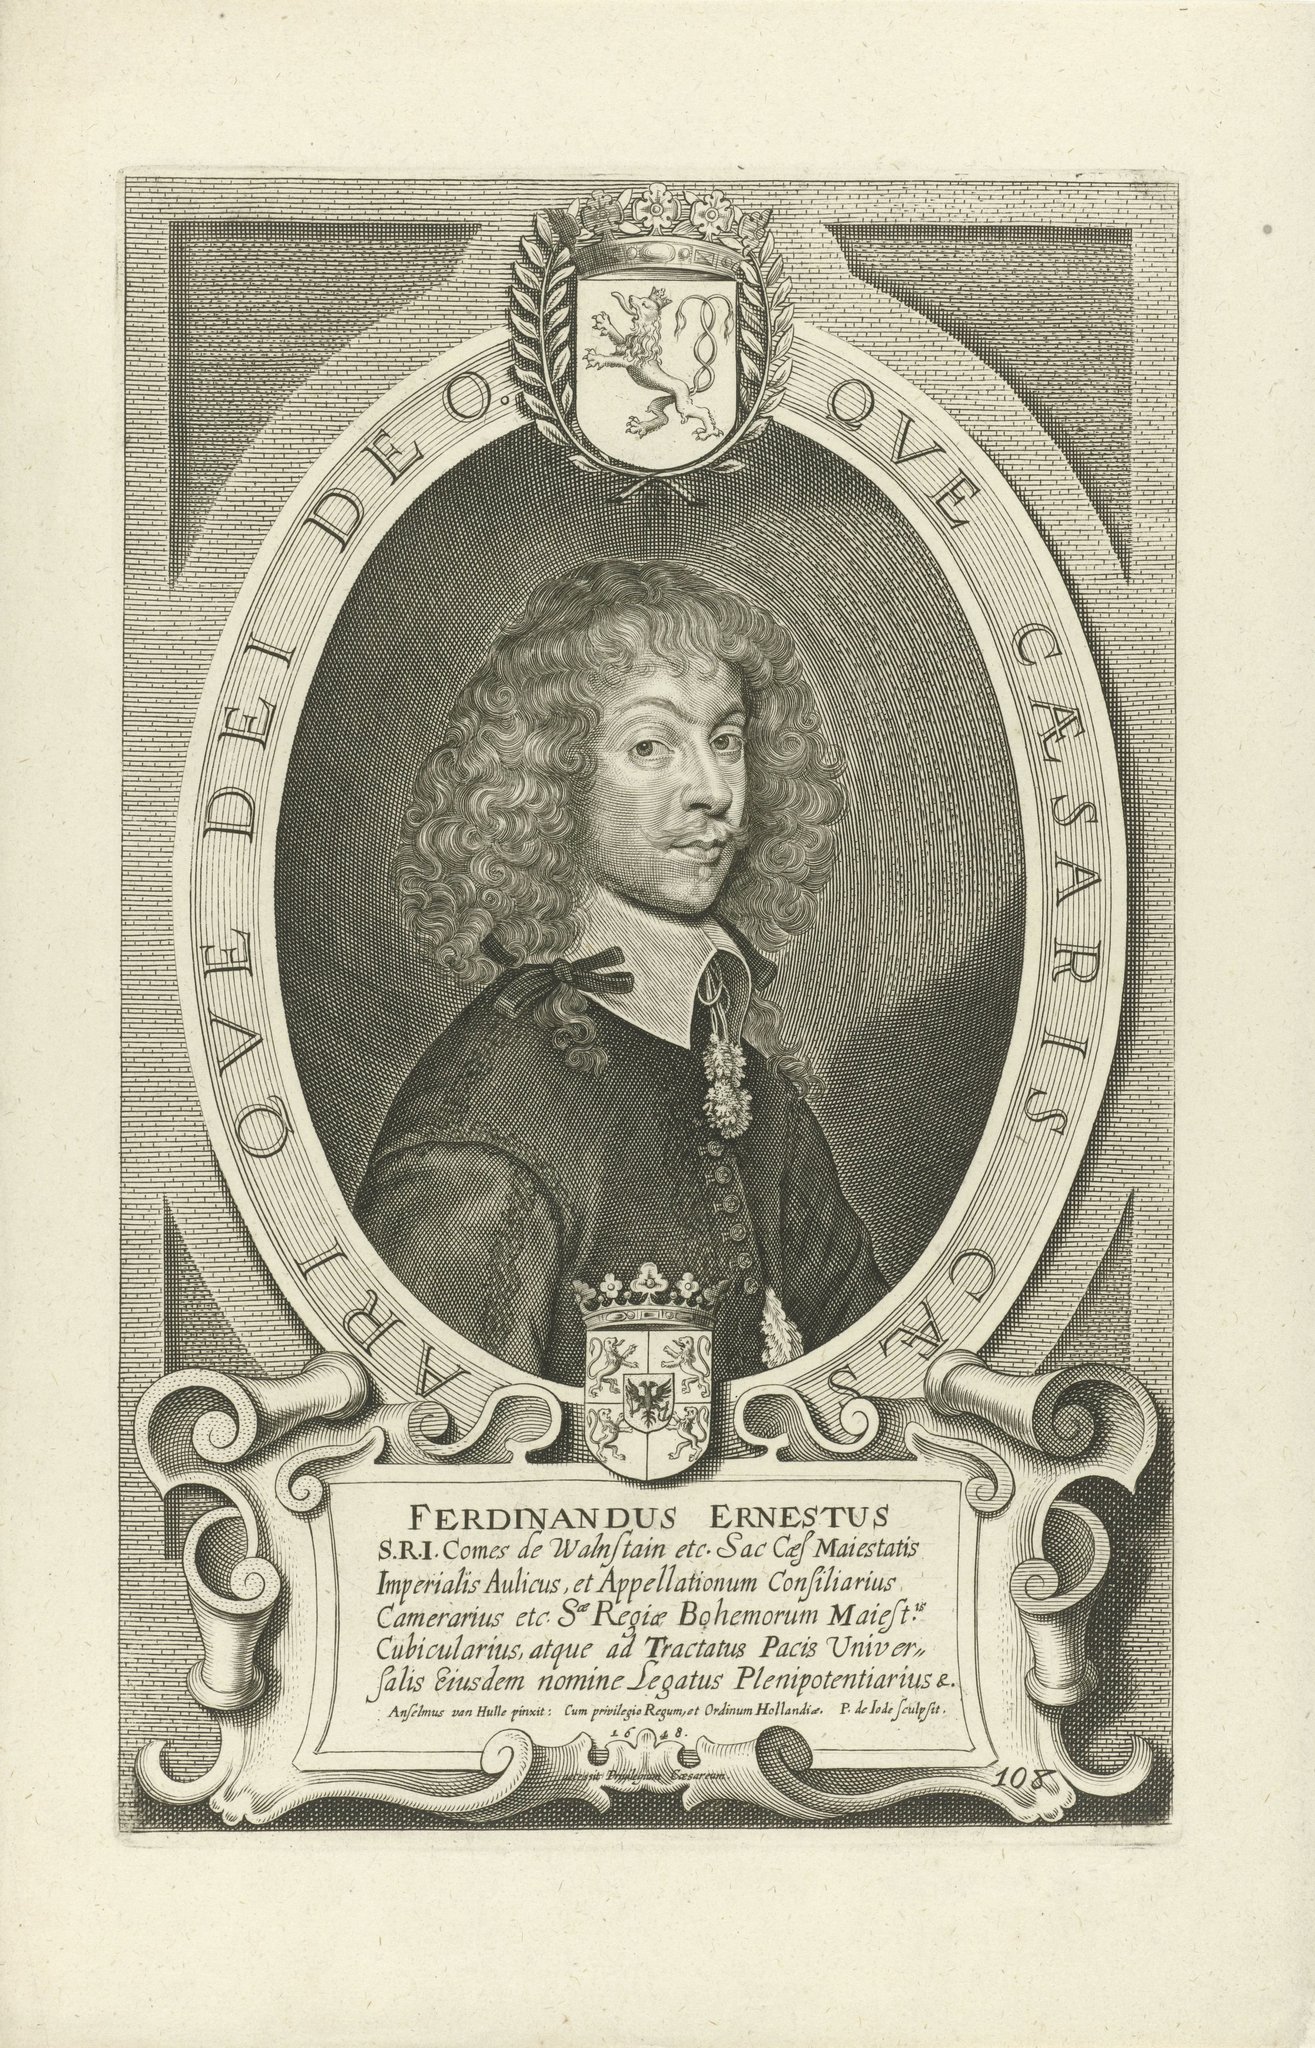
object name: print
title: Portret van Ferdinand Ernst, graaf van Wallenstein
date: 1648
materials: paper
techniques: engraving, etching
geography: antwerp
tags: ferdinand ernst (graaf van wallenstein)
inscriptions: collector's mark: Lugt 2228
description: Busteportret van Ferdinand Ernst, graaf van Wallenstein. Rechtsonder: 108. Het portret is gevat in een ovale omlijsting met het wapenschild van de geportretteerde en een randschrift in het Latijn. In de cartouche een zesregelig onderschrift in het Latijn. Prent uit een serie portretten naar schilderijen van Anselmus van Hulle van alle gedelegeerden bij de vredesonderhandelingen te Münster en Osnabrück.